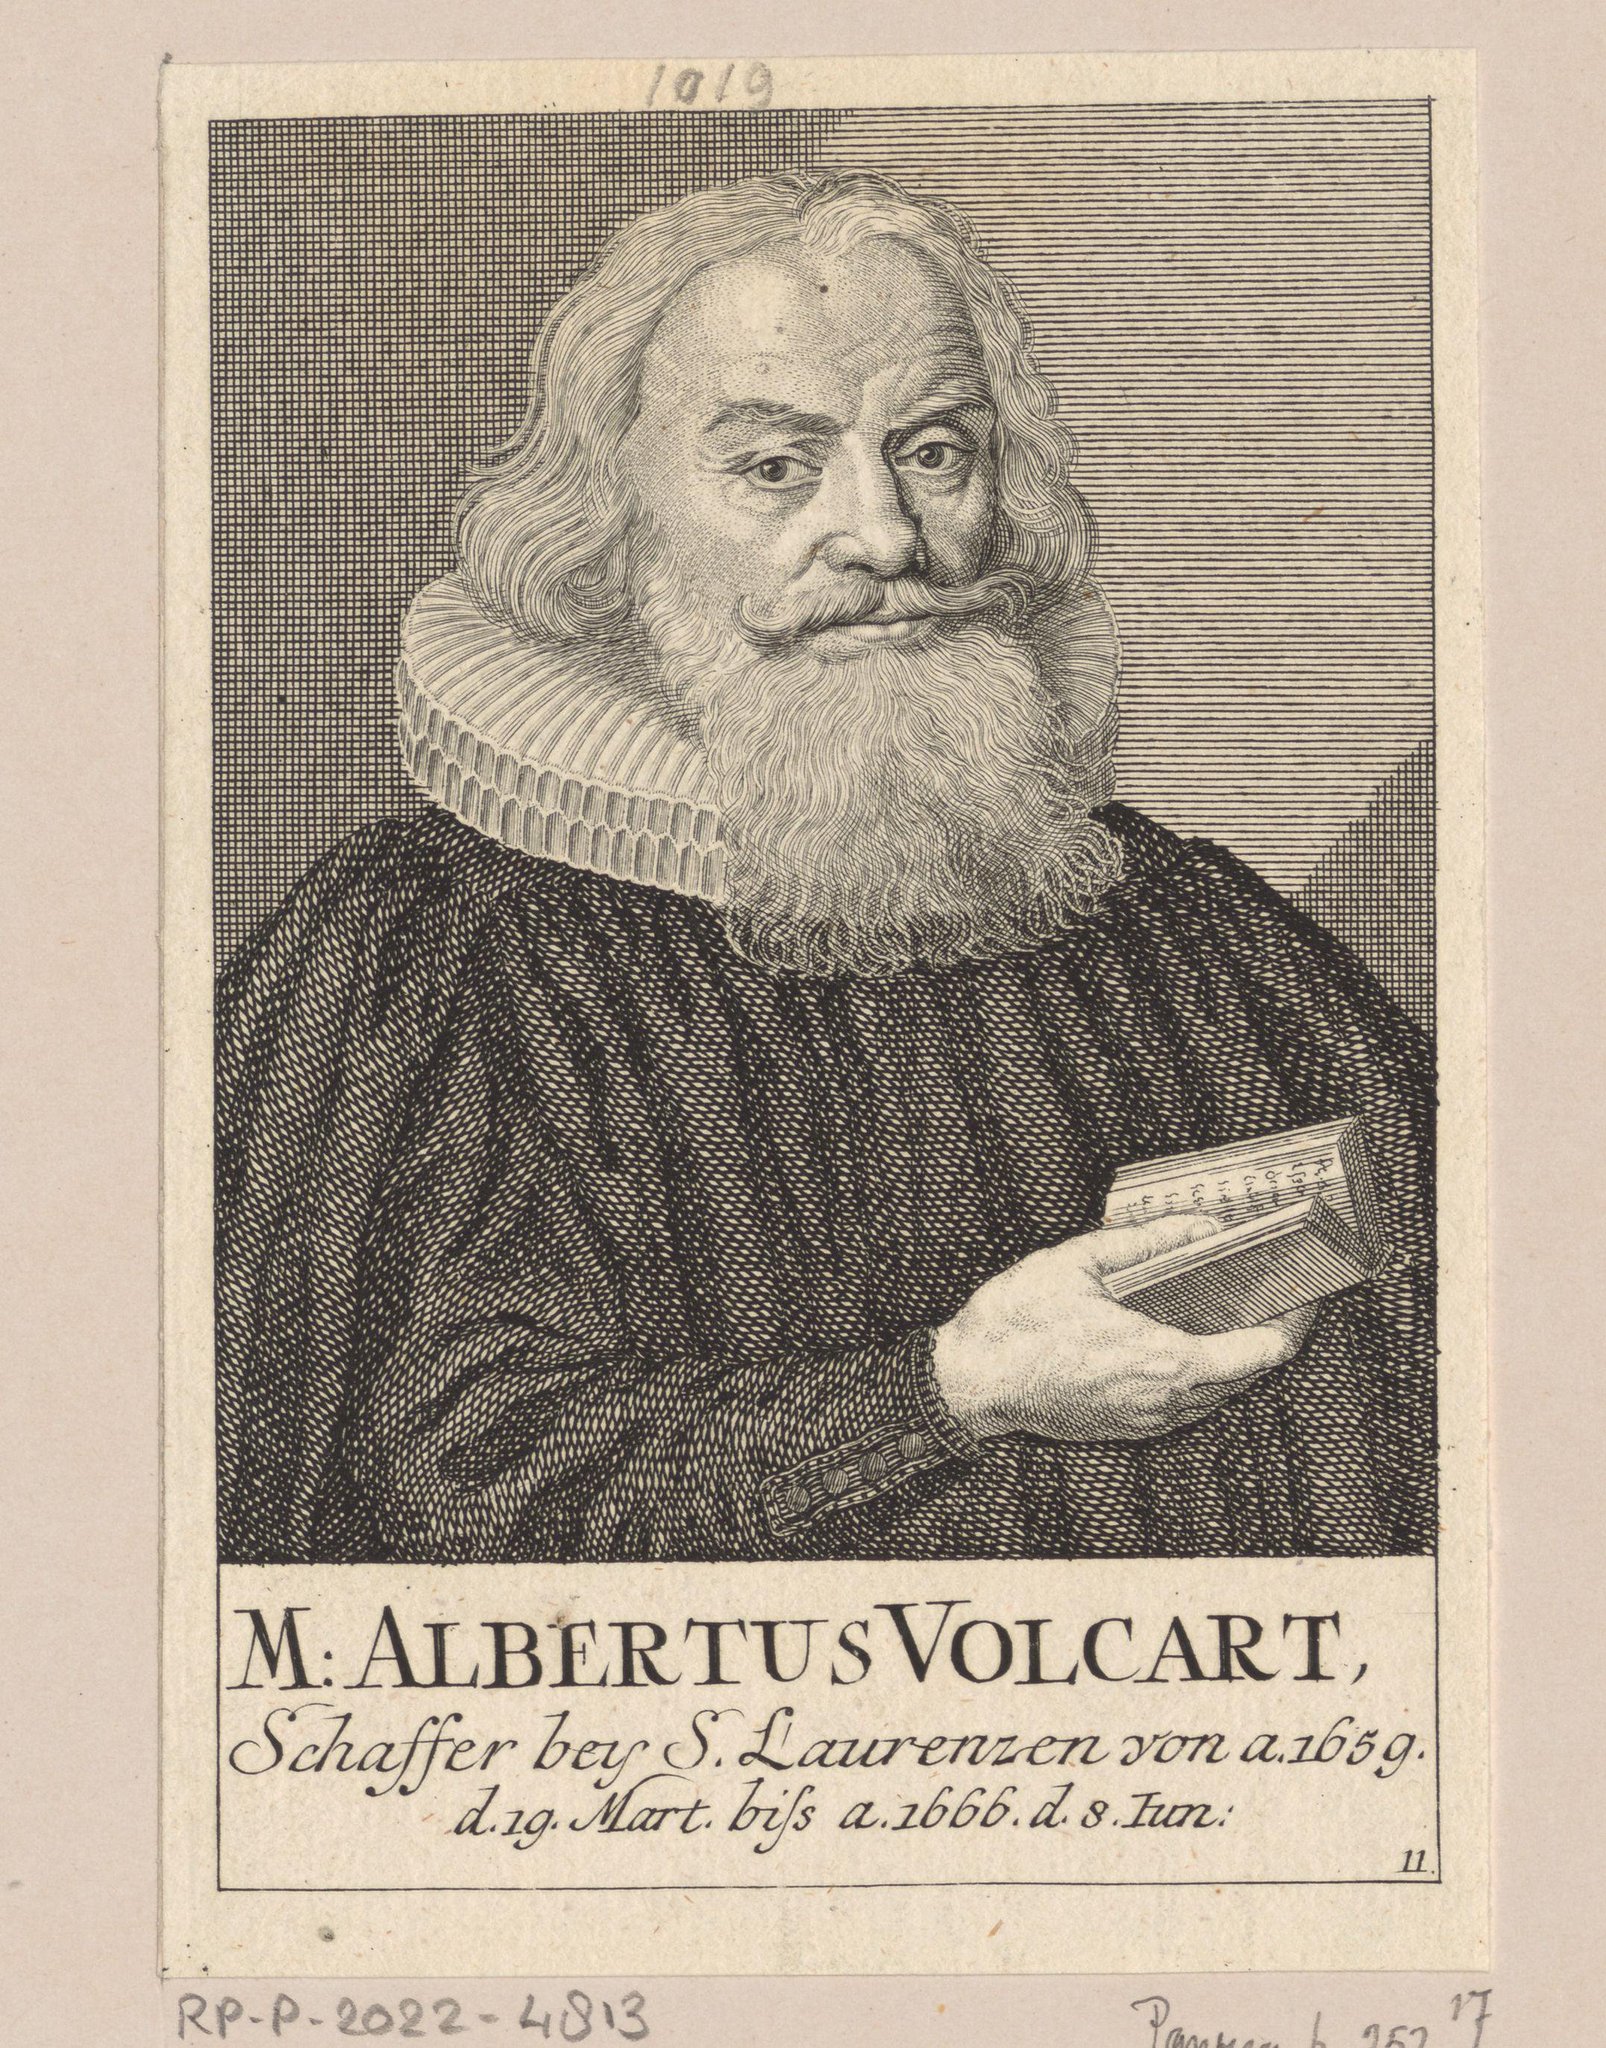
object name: book illustration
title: Portret van Albrecht Volckhard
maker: christoph melchior roth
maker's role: print maker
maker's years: 1720-1798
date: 1756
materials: paper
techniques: engraving, etching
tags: theologian, historical persons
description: Prent waarschijnlijk uit: Würfel, Andreas. Diptycha ecclesiae Laurentianae (...). Neurenberg: Christoph Melchior Roth, 1756.